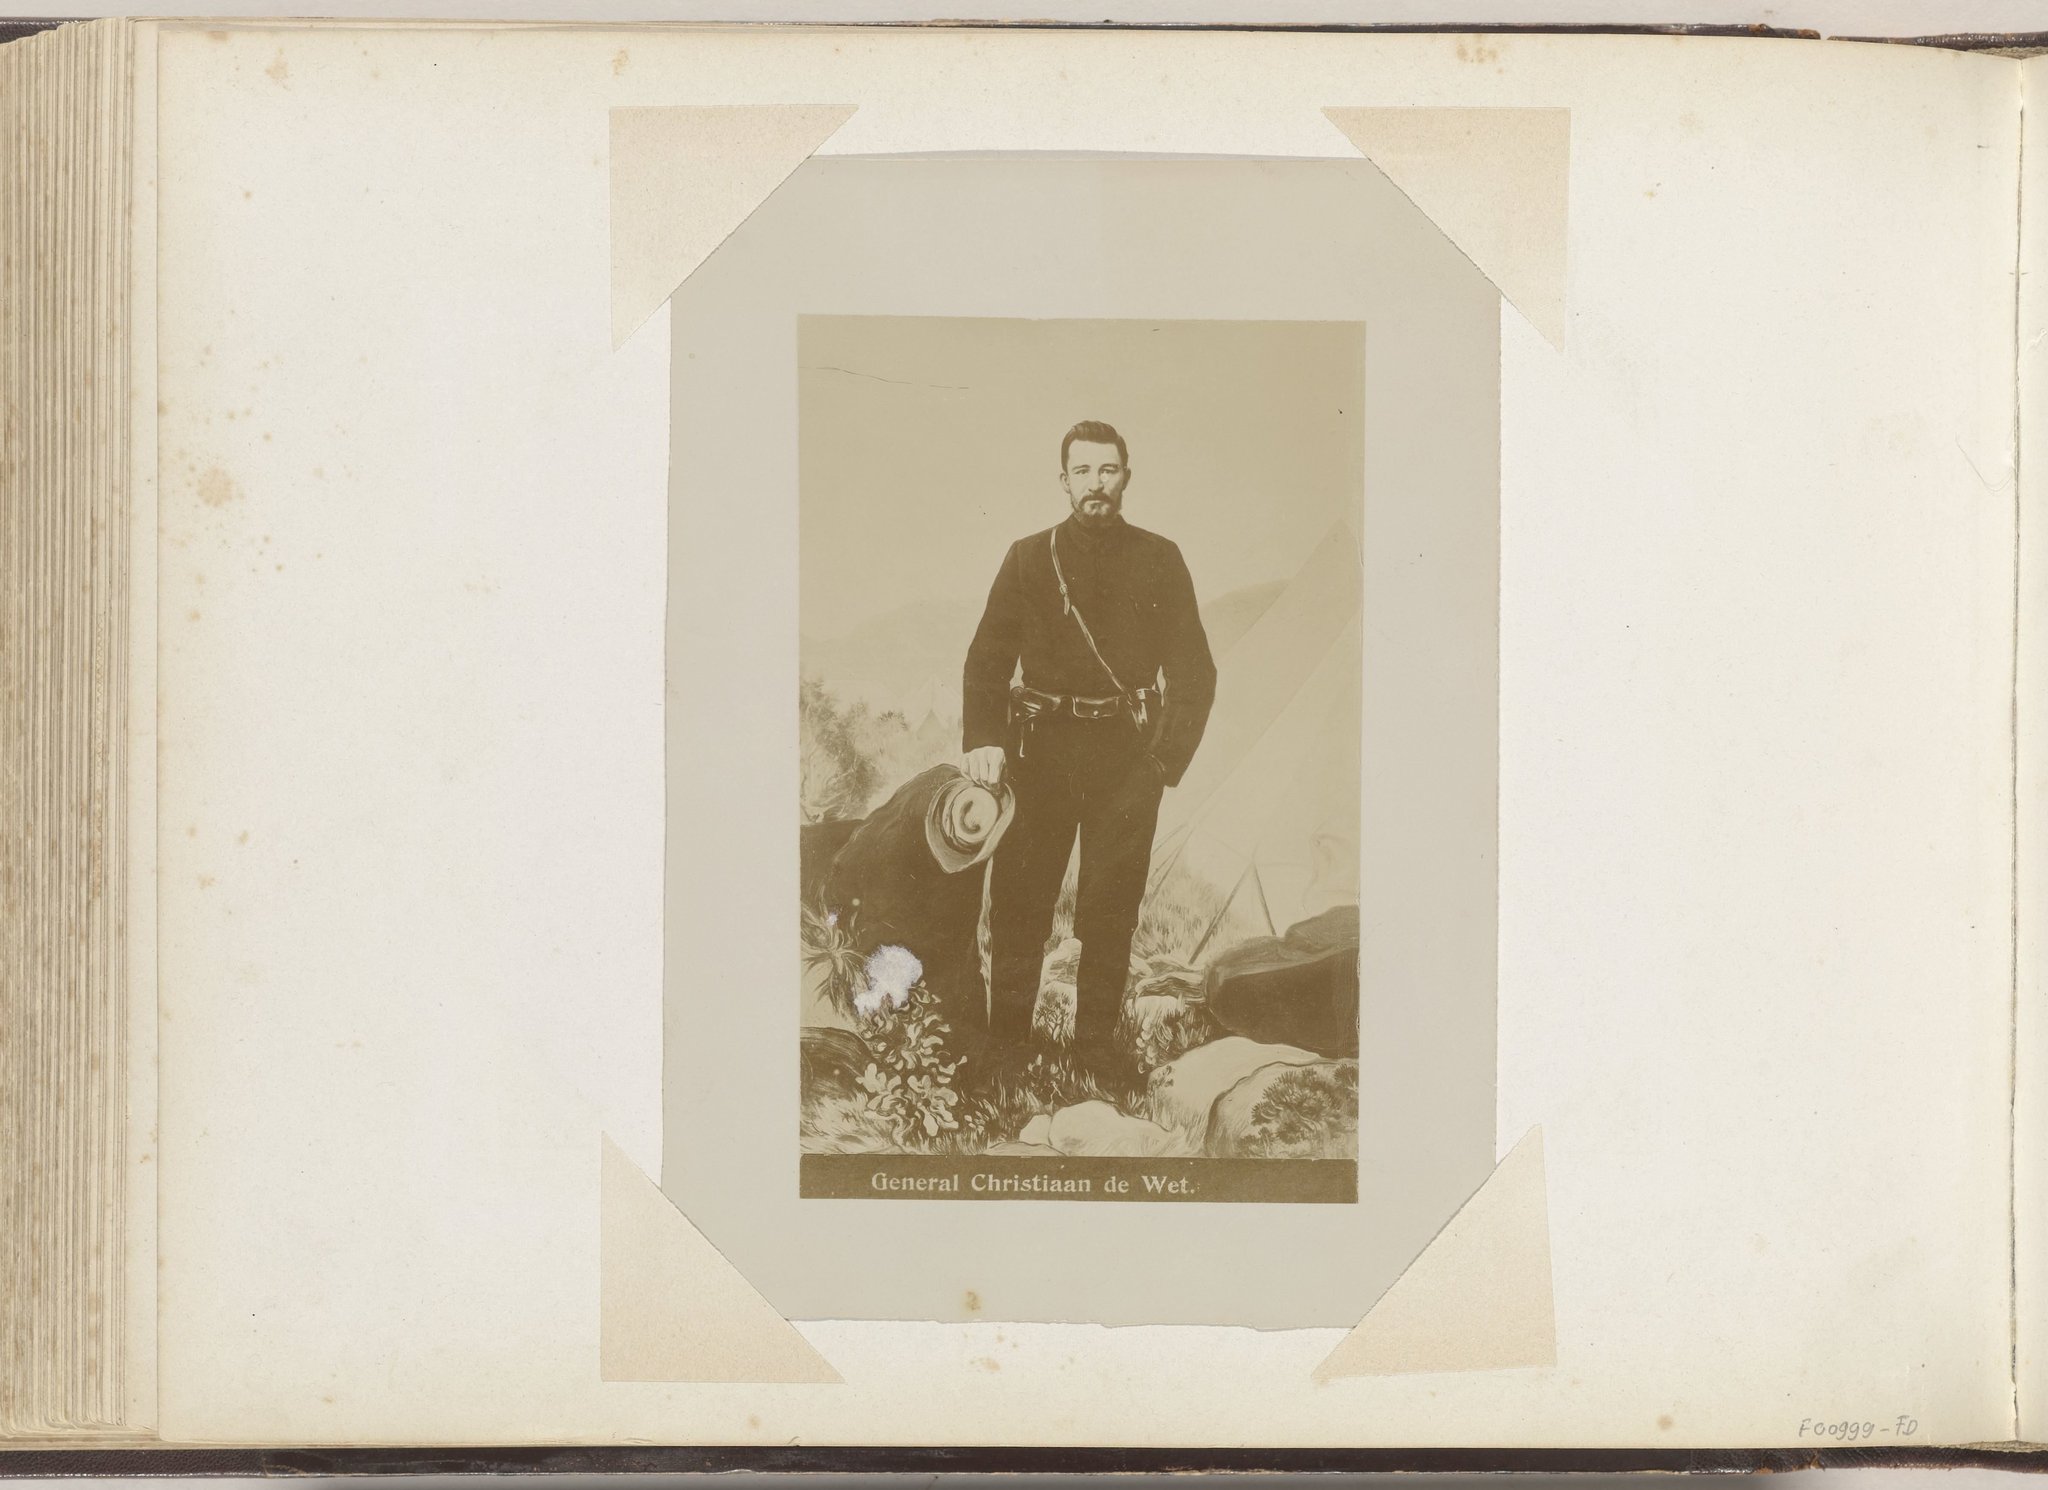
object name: photograph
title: Reproductie van (vermoedelijk) een tekening van een portret van generaal Christiaan de Wet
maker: Anonymous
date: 1899-1902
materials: paper, photographic support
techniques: gelatin silver print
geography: south africa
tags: politician, commander-in-chief, general, marshal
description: Onderdeel van Album met 191 foto's van een reis naar en door Zuid-Afrika.